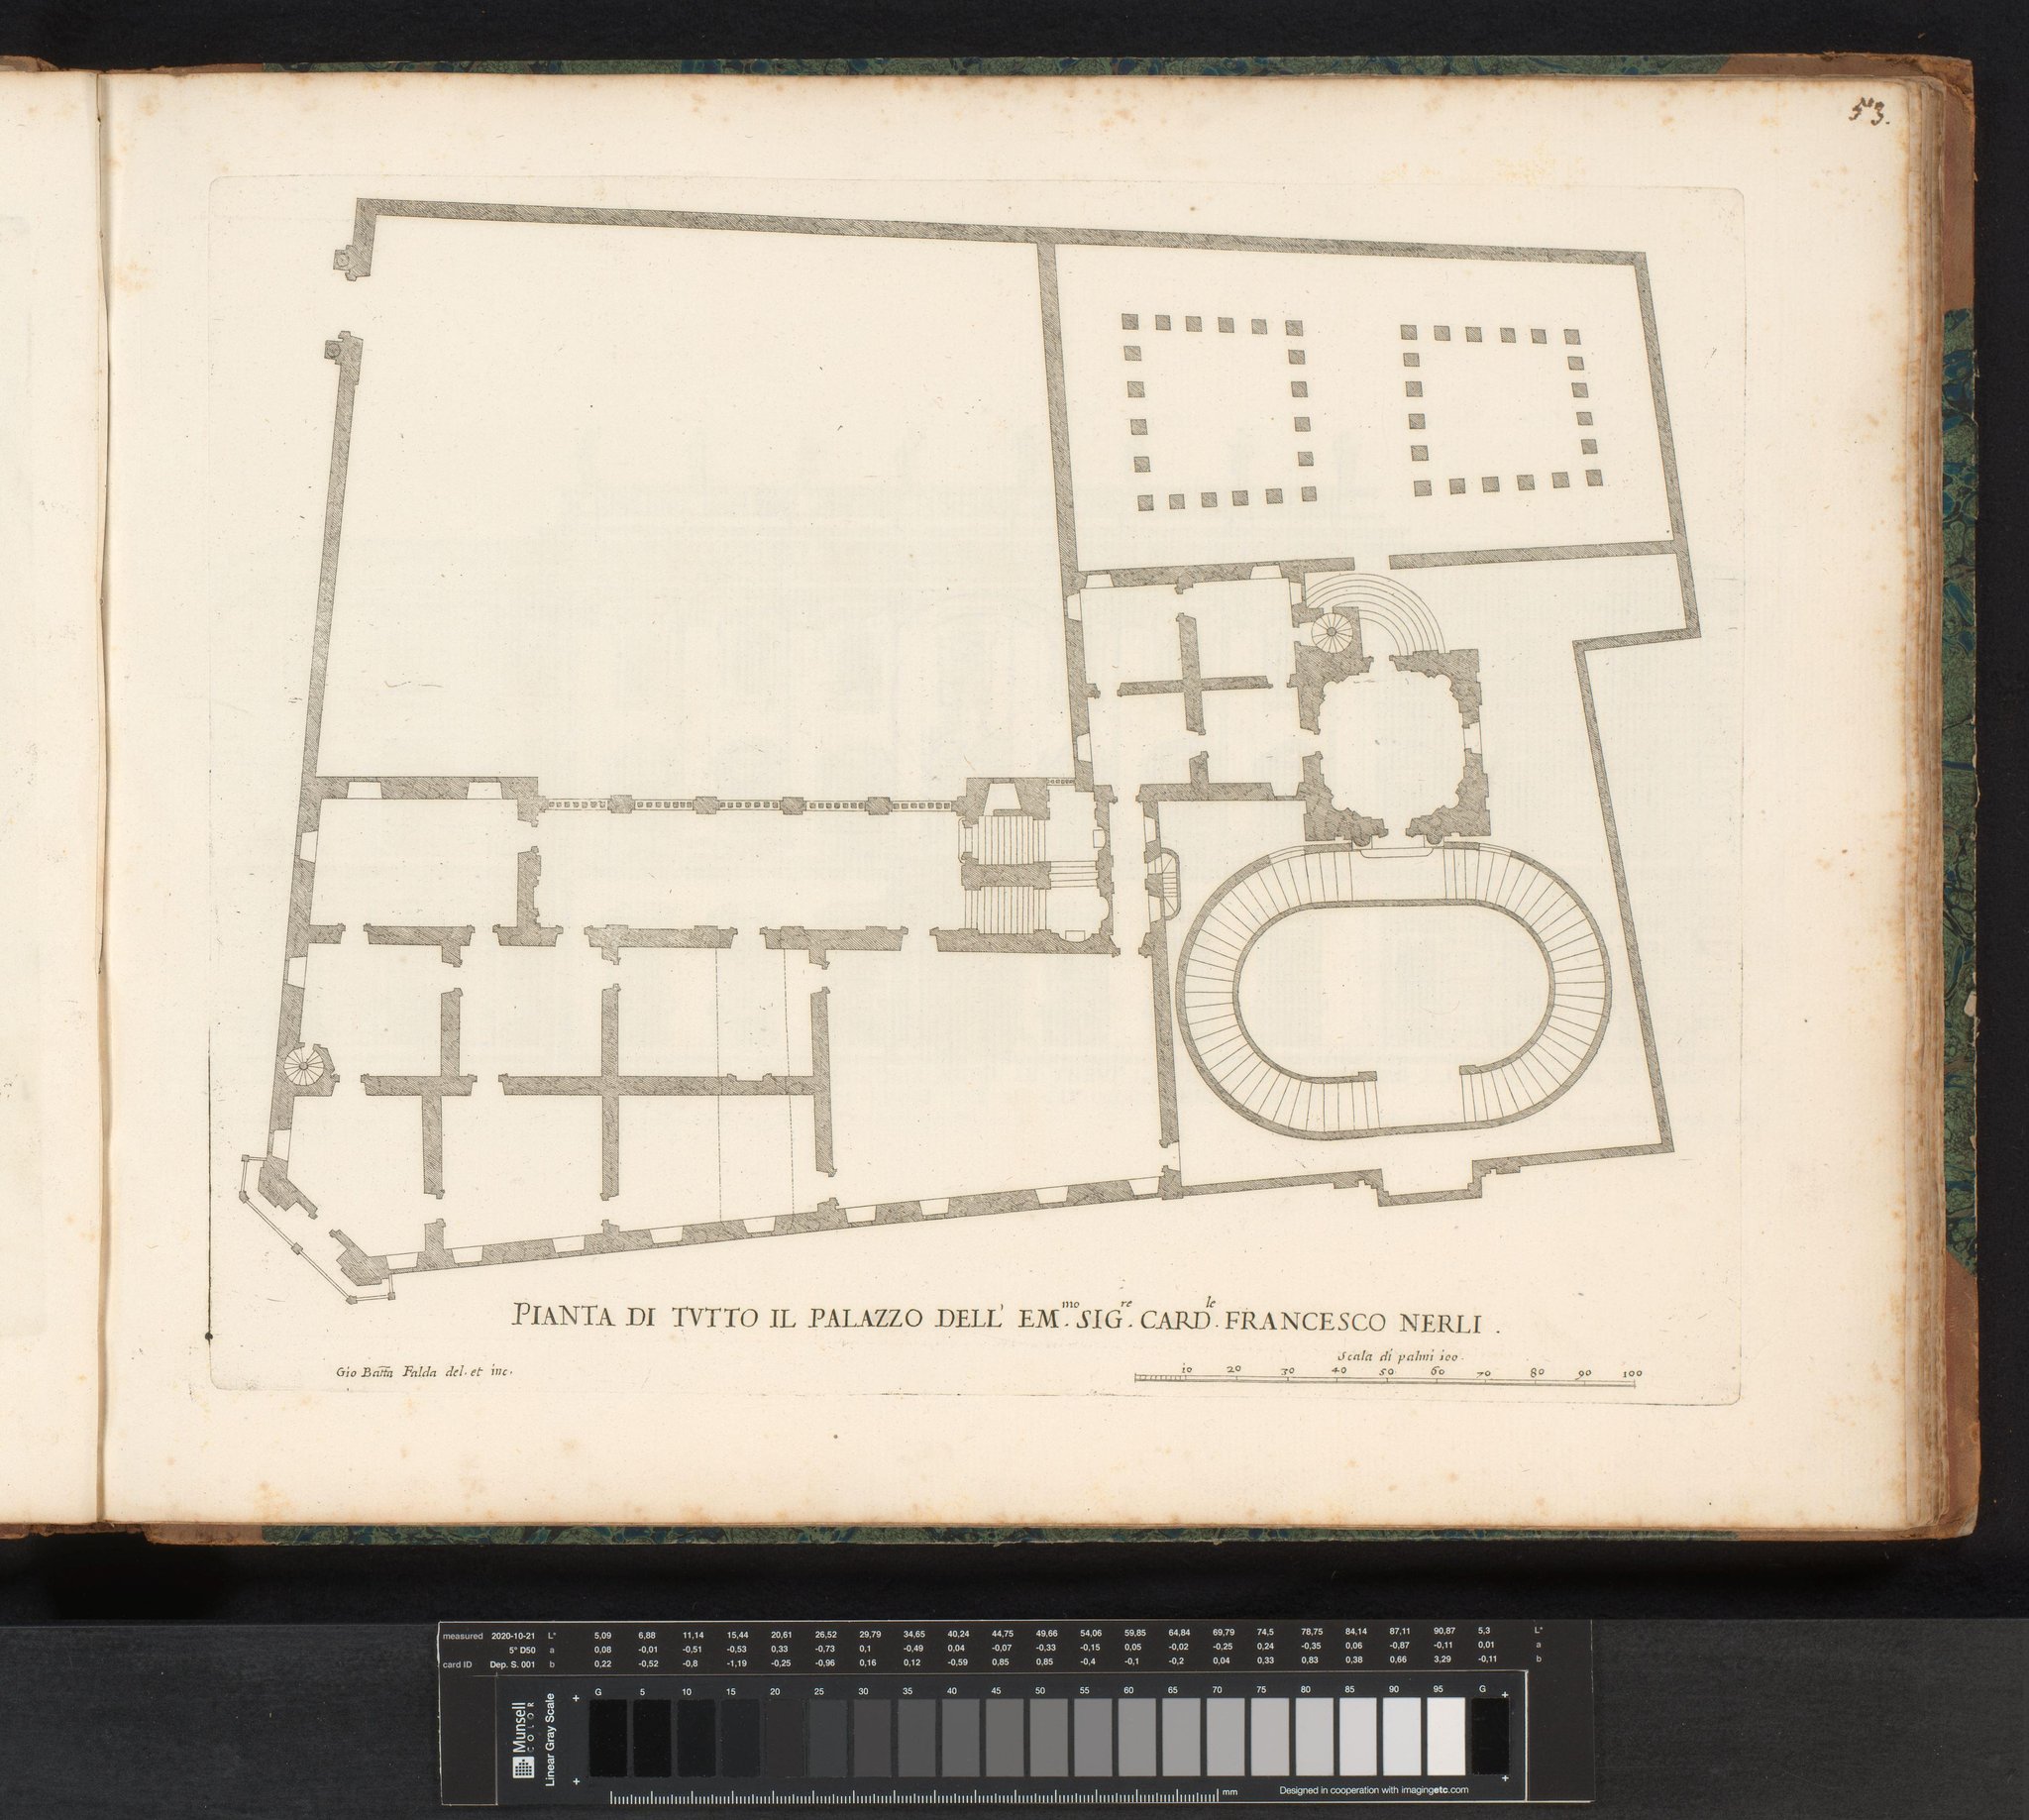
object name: print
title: Romeinse paleizen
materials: paper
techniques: etching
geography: vatican city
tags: rome, palace, façade (of house or building), plan ~ architecture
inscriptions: number: ‘53’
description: Deze prent maakt deel uit van de reeks getiteld: Palazzi di Roma. Deze reeks bestaat uit twee boeken. Boek één getiteld: Palazzi di Roma dei più celebri architetti..., bestaat uit 44 prenten die worden toegeschreven aan Giovanni Battista Falda (naam staat enkel op prent 27) en uitgegeven door Giovanni Giacomo de'Rossi. Deze 44 prenten zijn bekend in twee staten (met en zonder nummer). Boek twee getiteld: Nuovi disegni dell'architetture... libro secondo, bevat 66 prenten door Giovanni Battista Falda en Simone Felice. Deze 66 prenten zijn bekend in twee staten (met en zonder nummer).